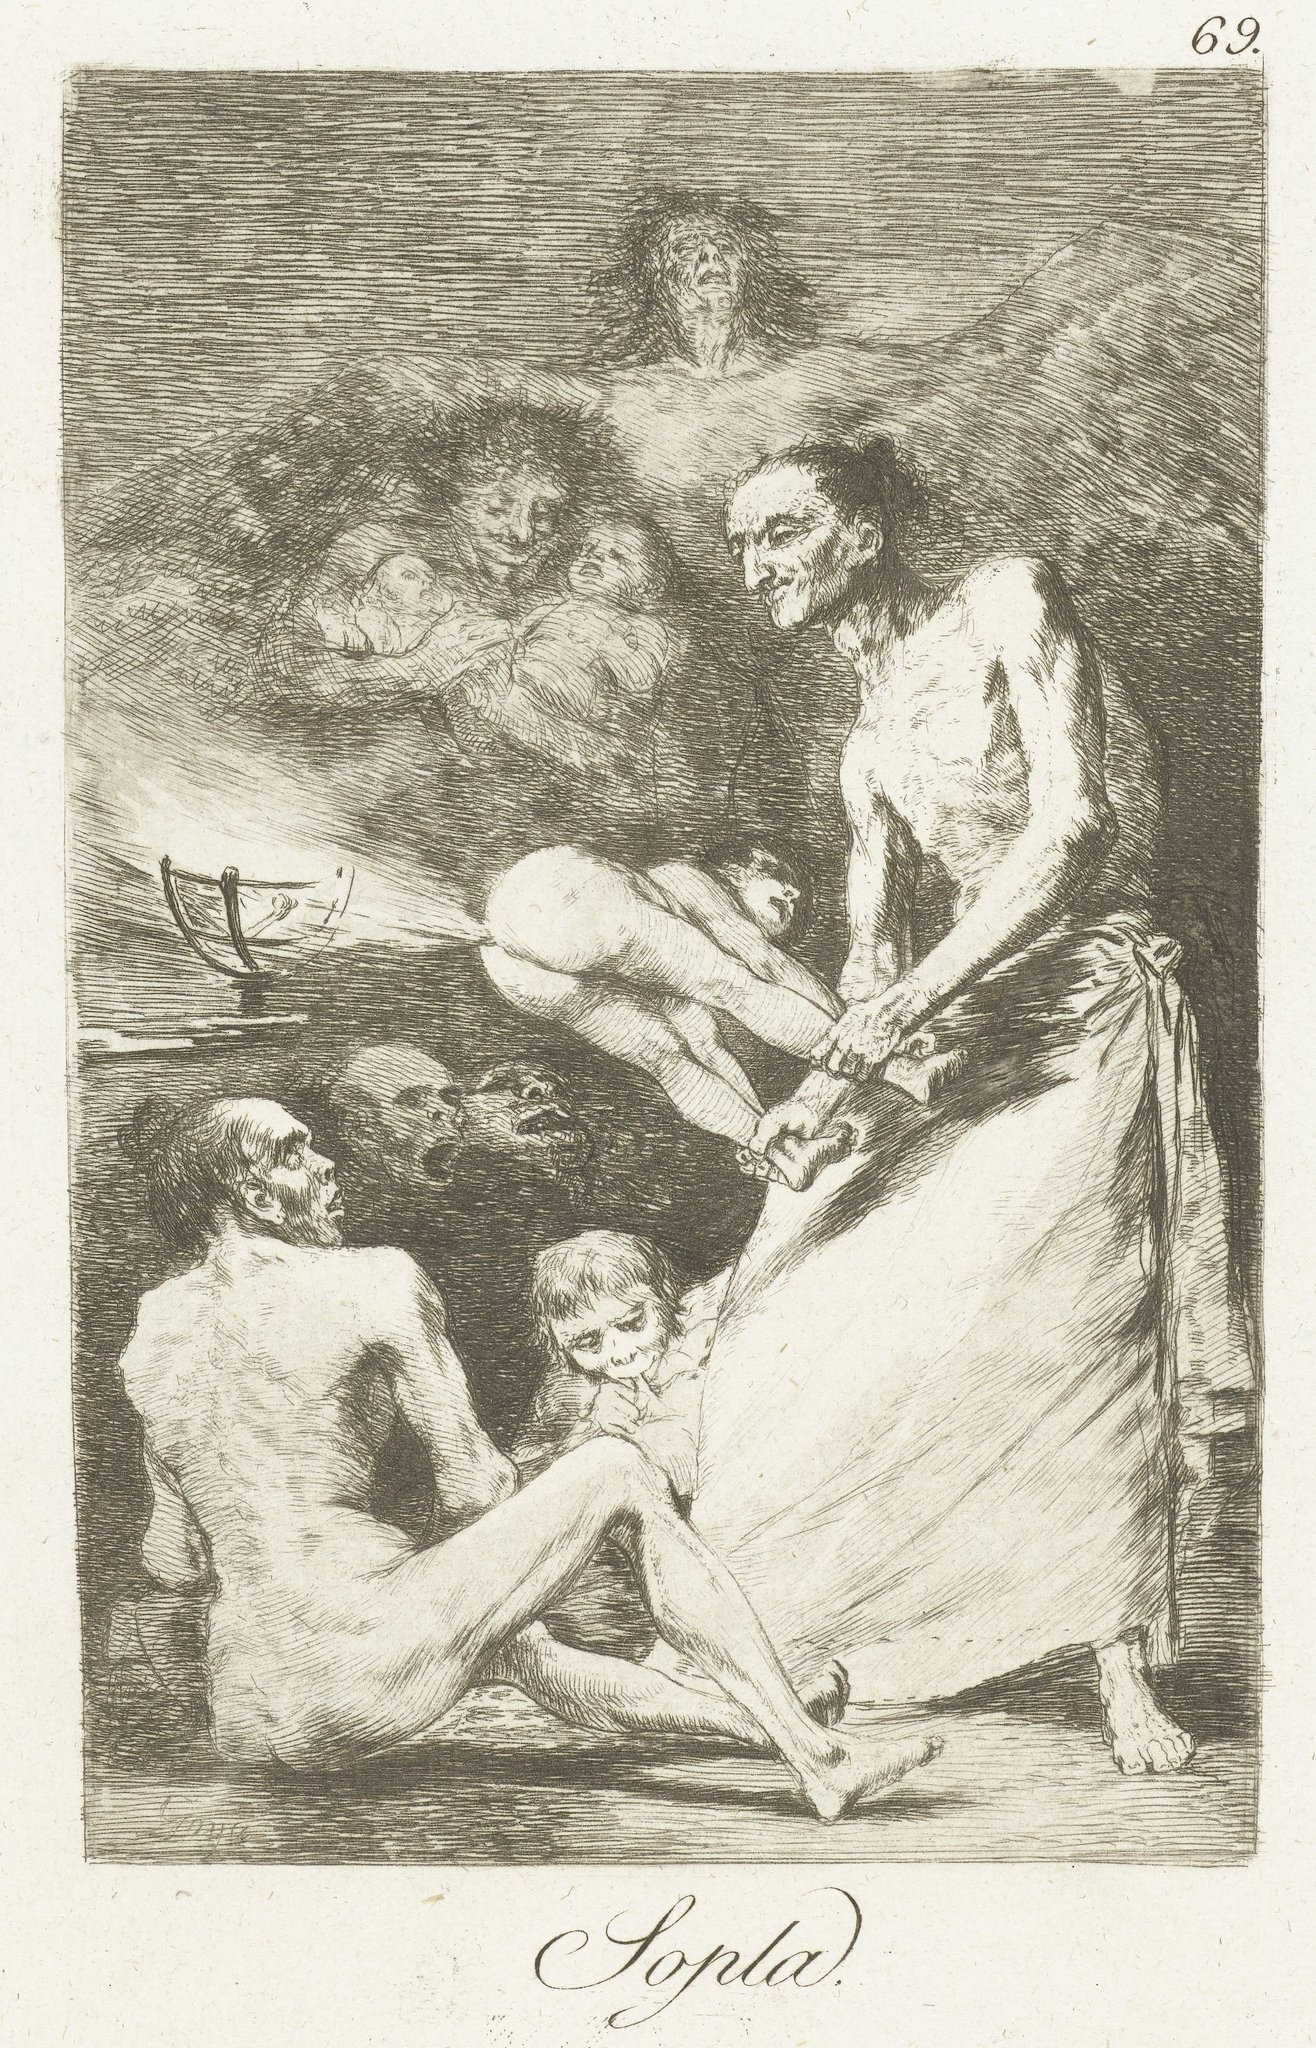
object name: print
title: Blaas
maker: francisco de goya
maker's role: draughtsman, painter, print maker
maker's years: 1746-1828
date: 1797-1799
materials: paper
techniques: aquatint, drypoint, etching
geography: spain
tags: witchcraft, sorcery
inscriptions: collector's mark: Lugt 2228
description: Een oude man met een kind, vastgehouden aan armen en benen. Uit het achterwerk van het kind blaast lucht. Op de grond een aantal figuren, in de lucht twee duivels met twee baby's. Negenenzestigste prent uit de serie Los Caprichos.